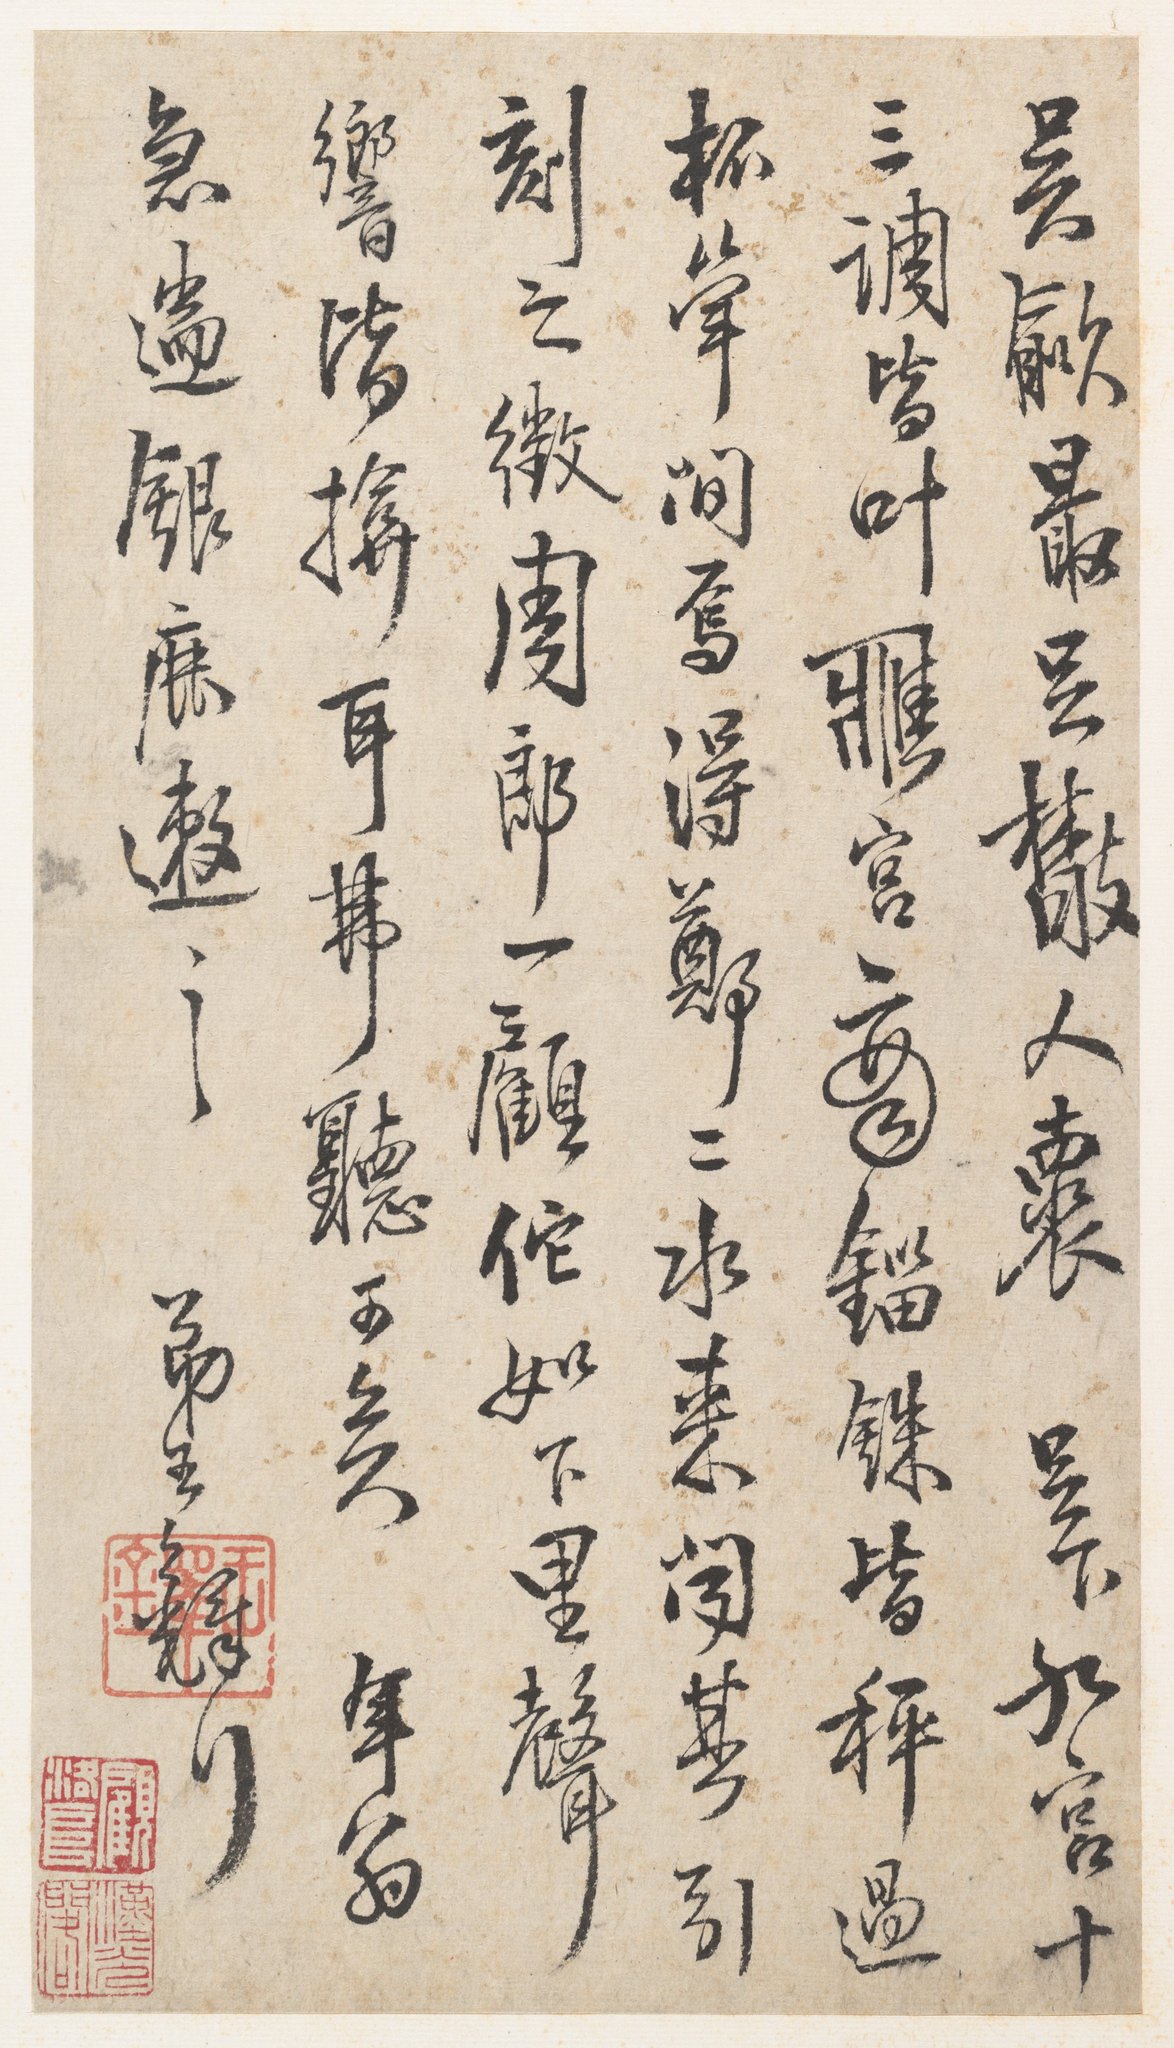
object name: album leaf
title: Letter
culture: chinese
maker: wang duo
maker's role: artist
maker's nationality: chinese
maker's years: 1592-1652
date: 1592-1652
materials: gold, ink, paper